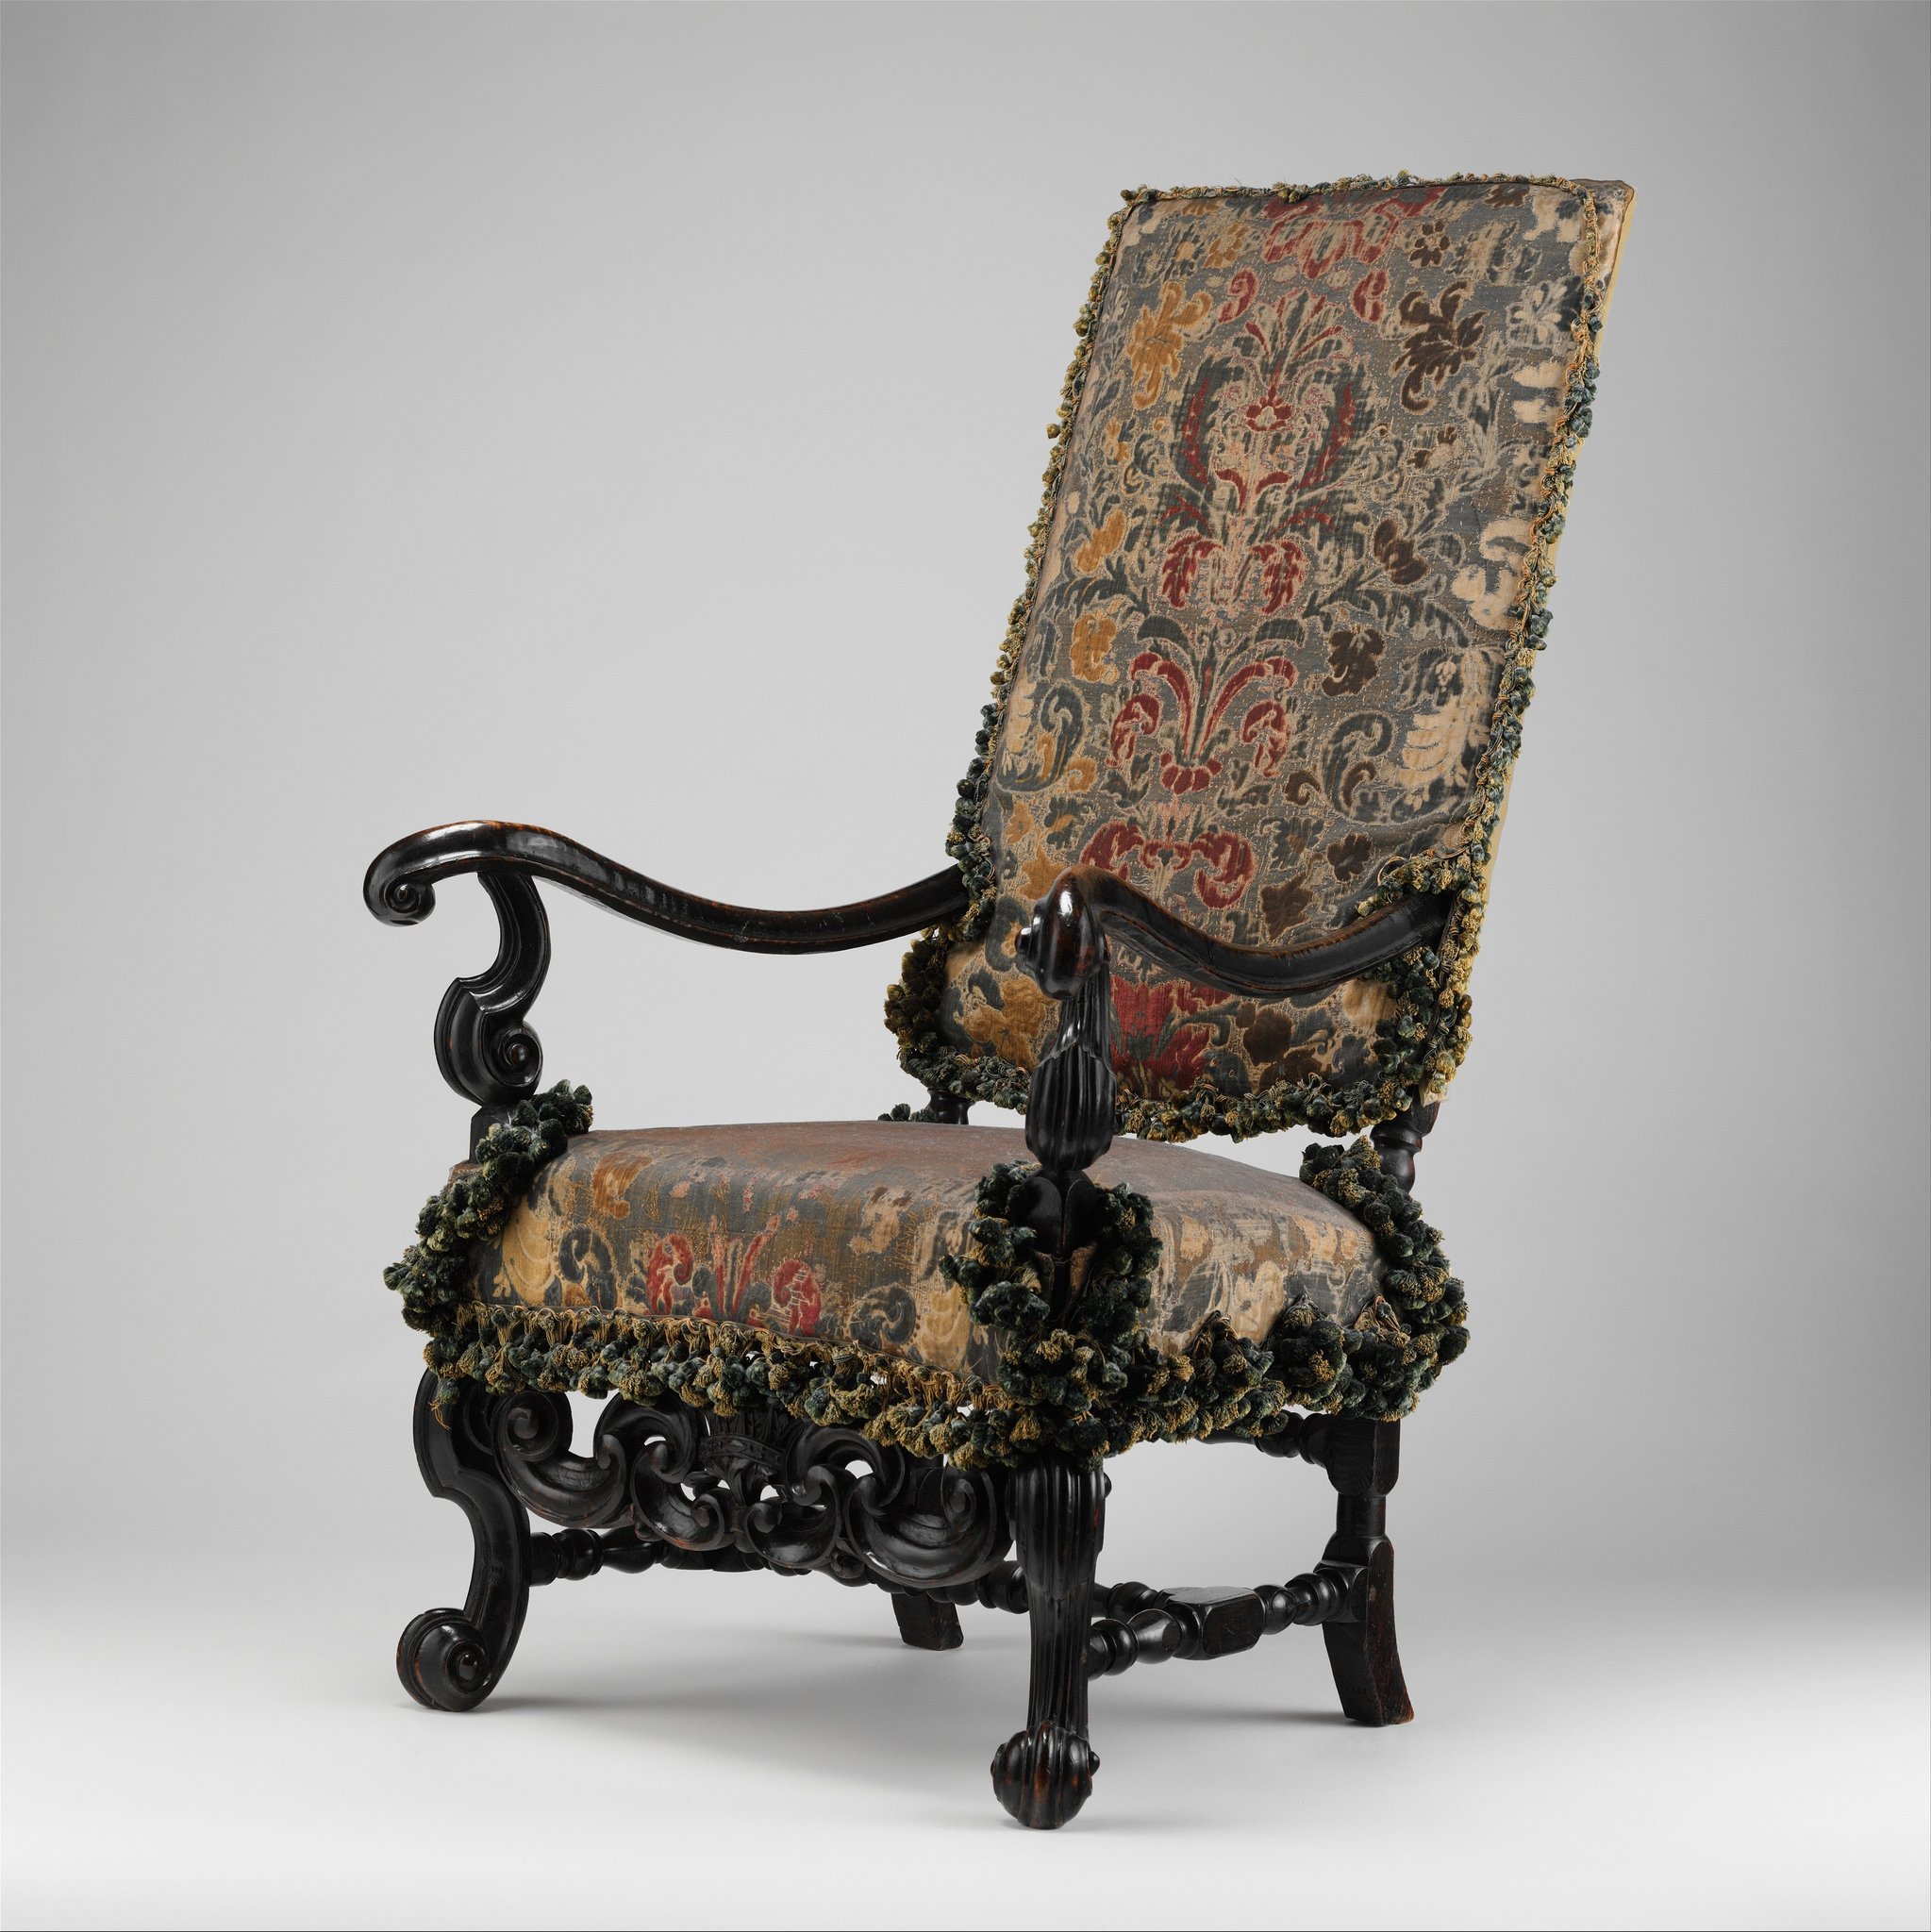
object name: armchair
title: Upholstered armchair, originally from a set of eight, from Burley-on-the-Hill, Rutland (one of a pair)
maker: thomas roberts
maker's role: maker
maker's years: 1685-1714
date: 1689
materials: wood, velvet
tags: flowers